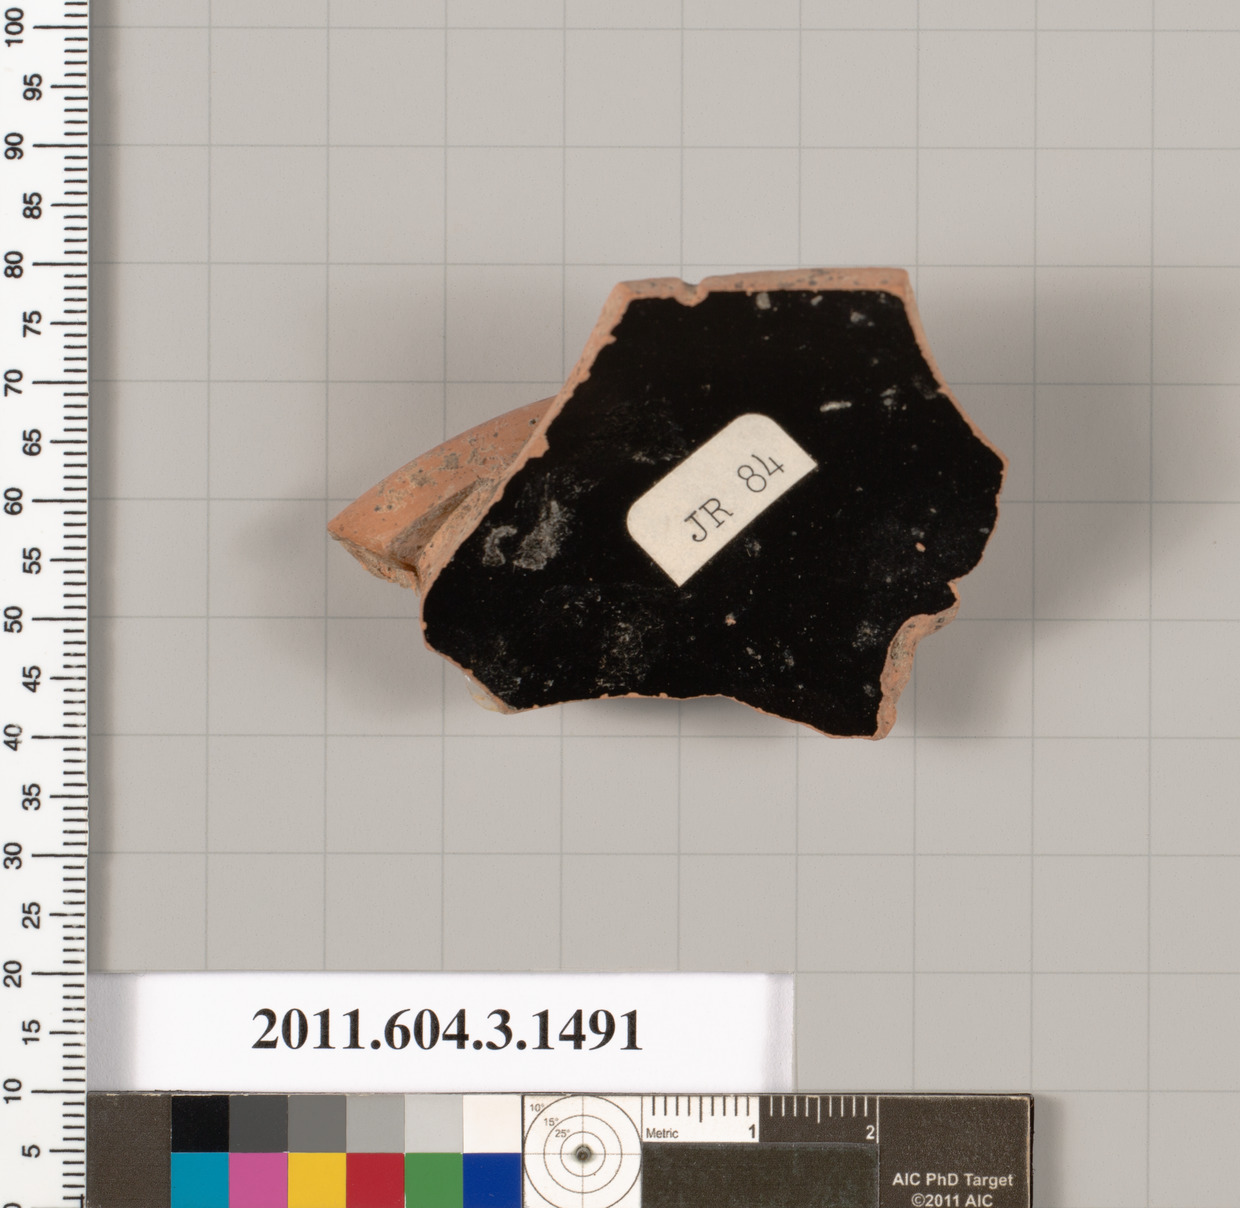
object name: skyphos fragment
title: Terracotta fragment of a skyphos (deep drinking cup)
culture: greek, attic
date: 600-401 BCE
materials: terracotta